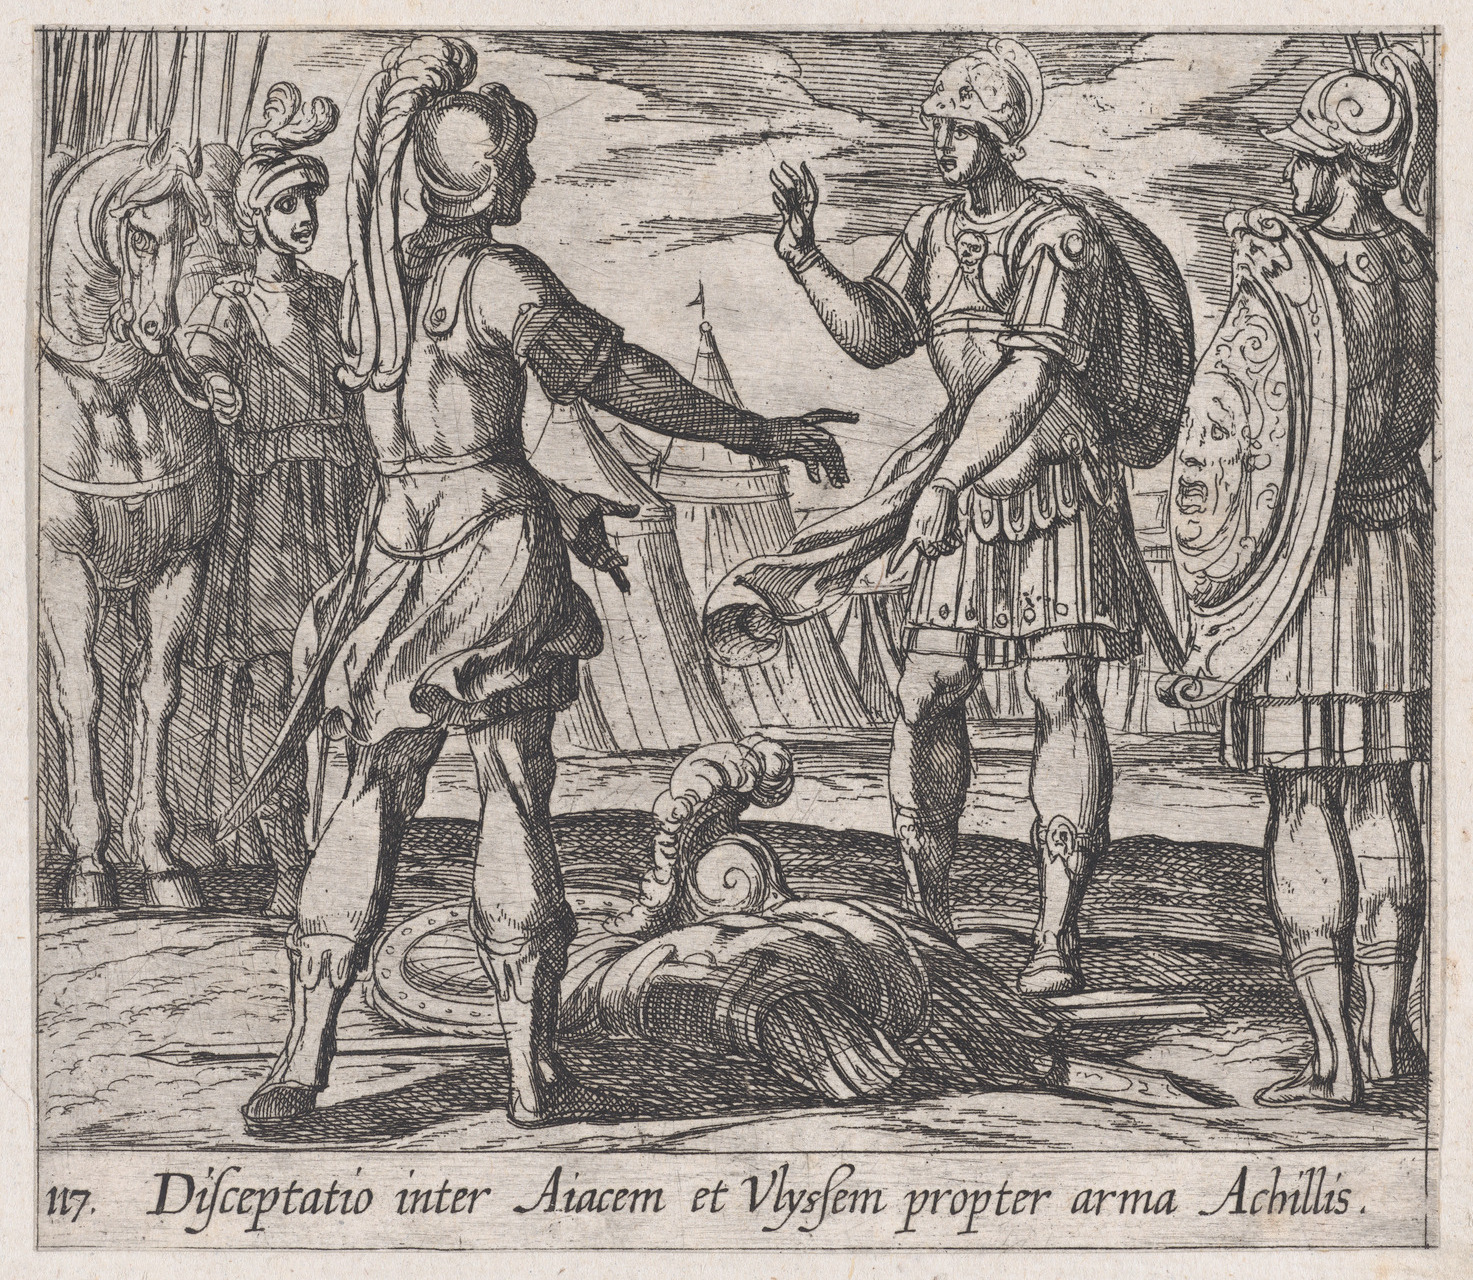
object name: print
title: Plate 117: The Dispute over Achilles' Armor (Disceptatio inter Aiacem et Ulyssem propter arma Achillis), from Ovid's 'Metamorphoses'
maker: antonio tempesta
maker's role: artist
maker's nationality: italian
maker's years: 1555-1630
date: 1606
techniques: etching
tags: tents,soldiers,armor,shields,horses